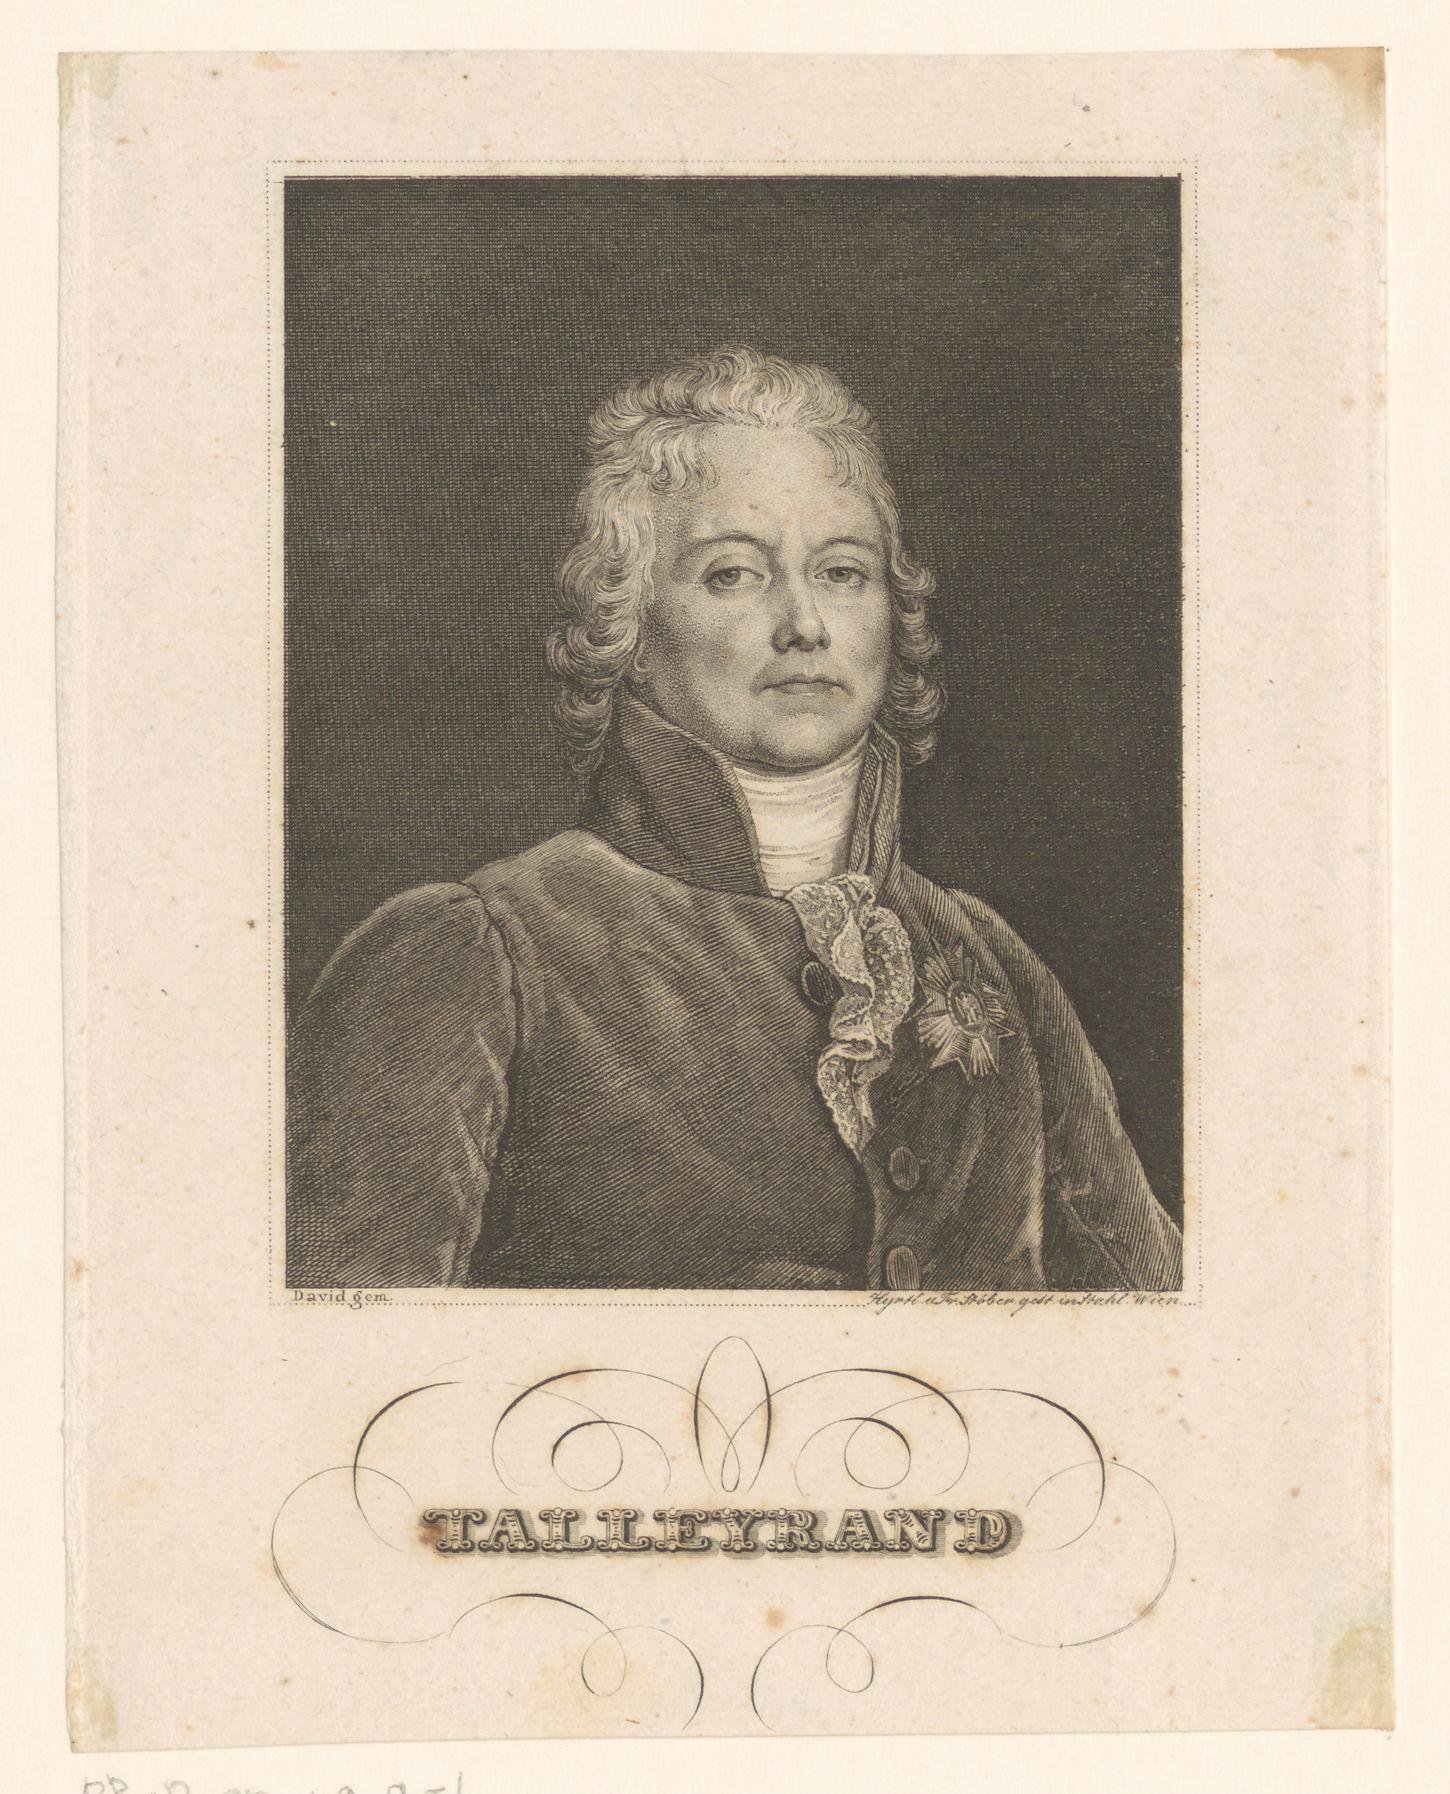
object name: print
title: Zeitgenossen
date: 1809-1868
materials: paper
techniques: engraving, etching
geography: vienna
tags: paris, politician, charles maurice hertog van talleyrand-périgord, historical persons, politician, e.g. party leader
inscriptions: collector's mark: Lugt 2228